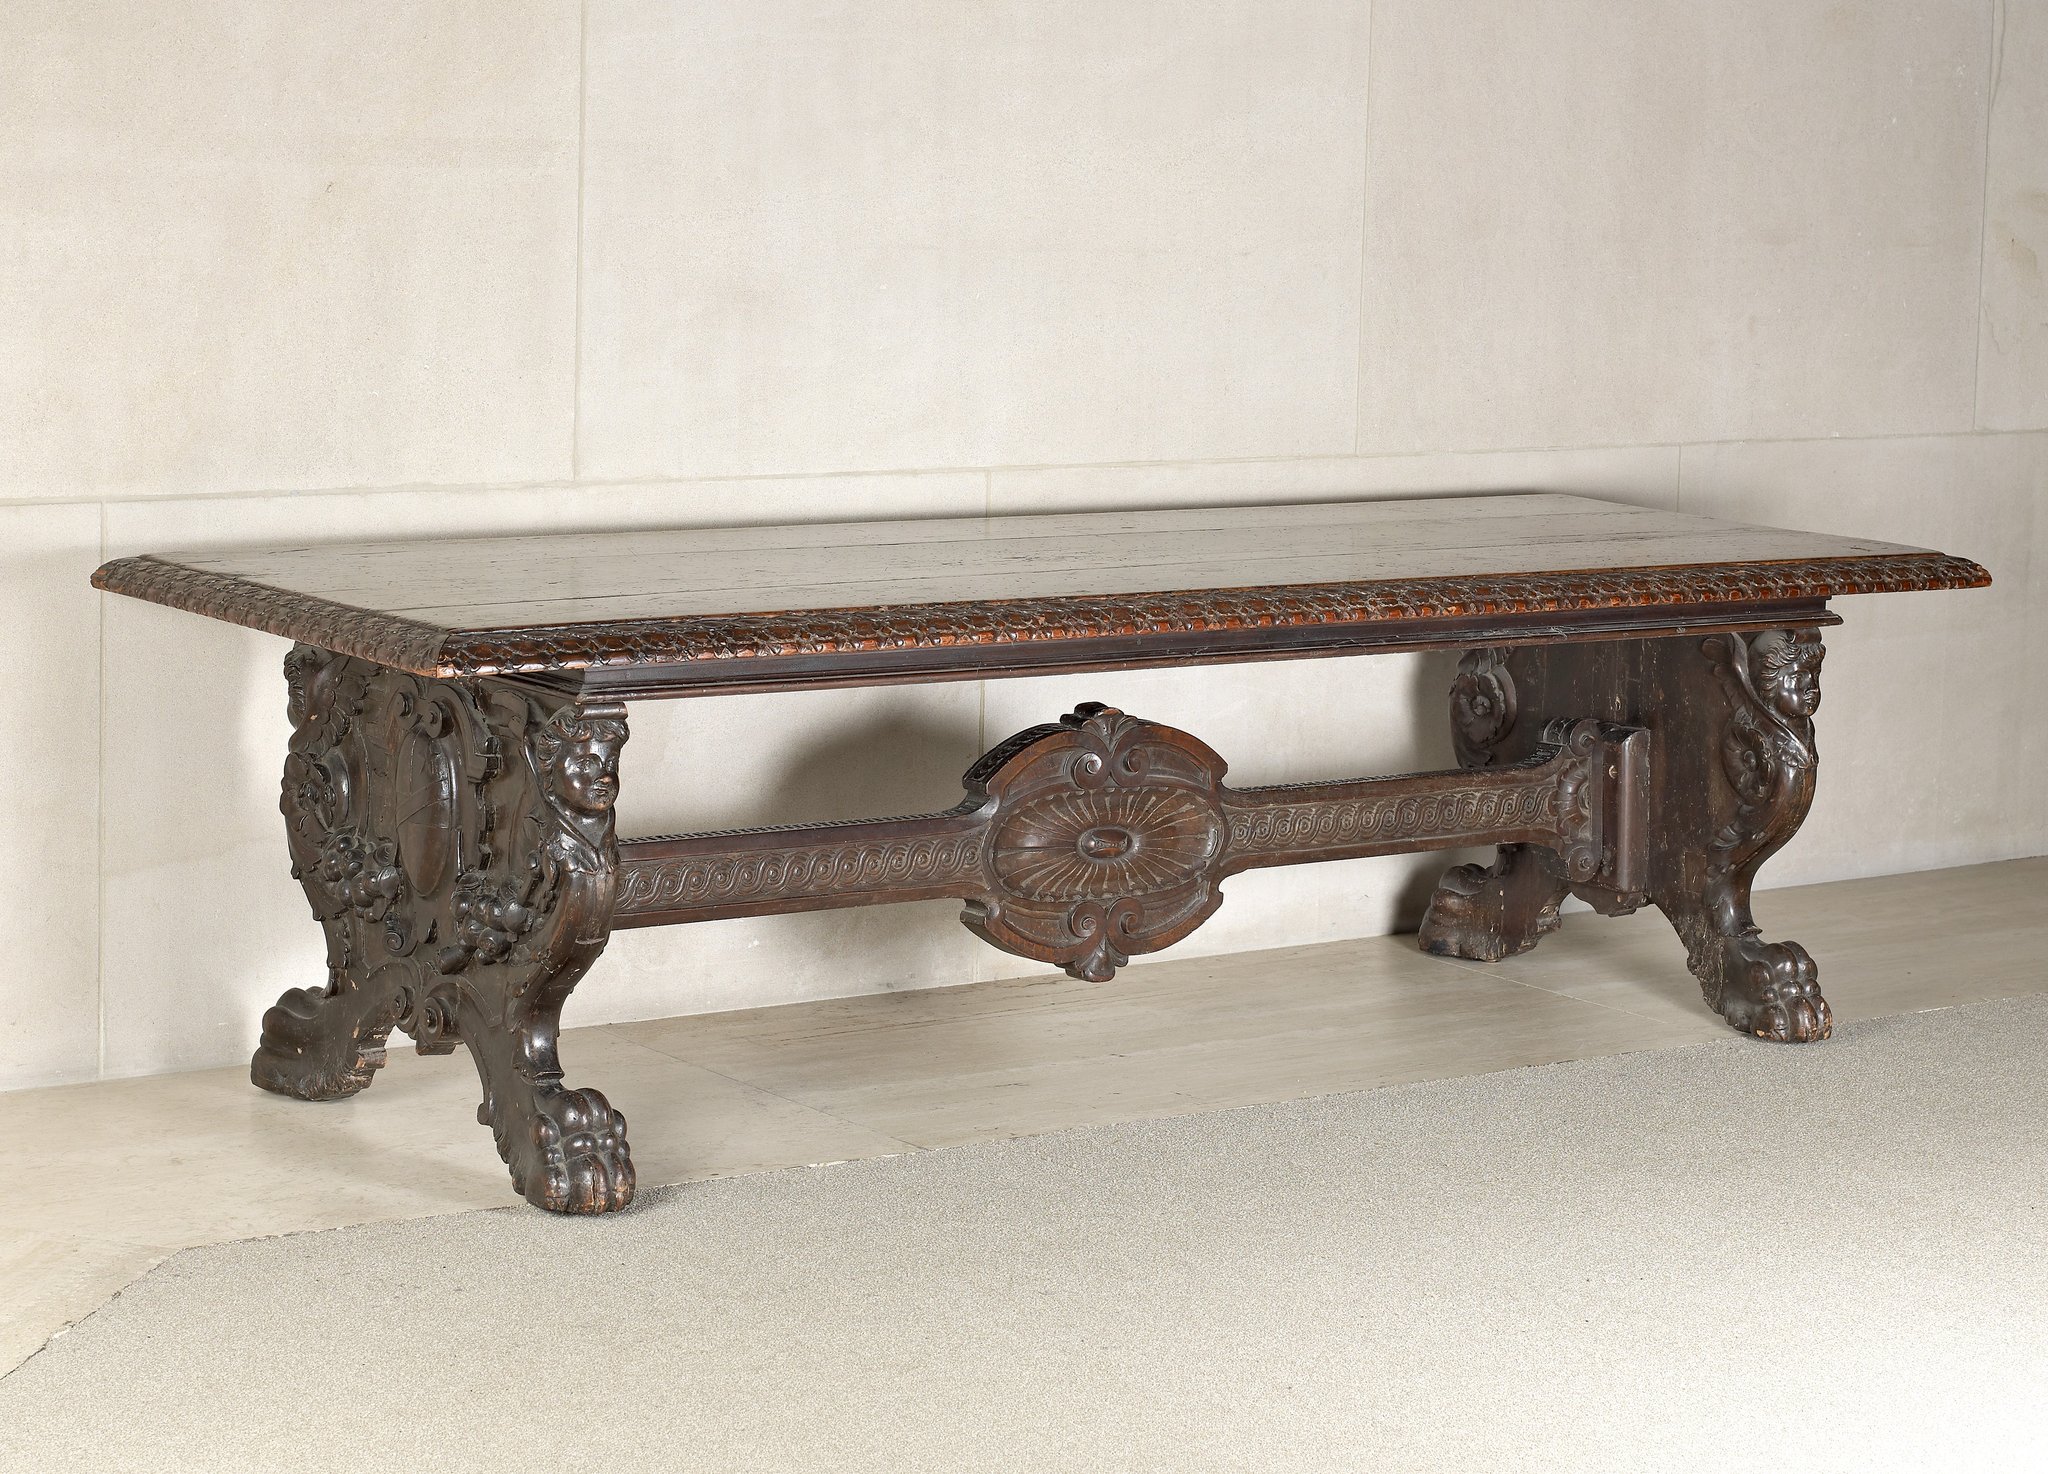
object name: table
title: Center table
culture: italian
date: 1801-1900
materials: wood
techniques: carving